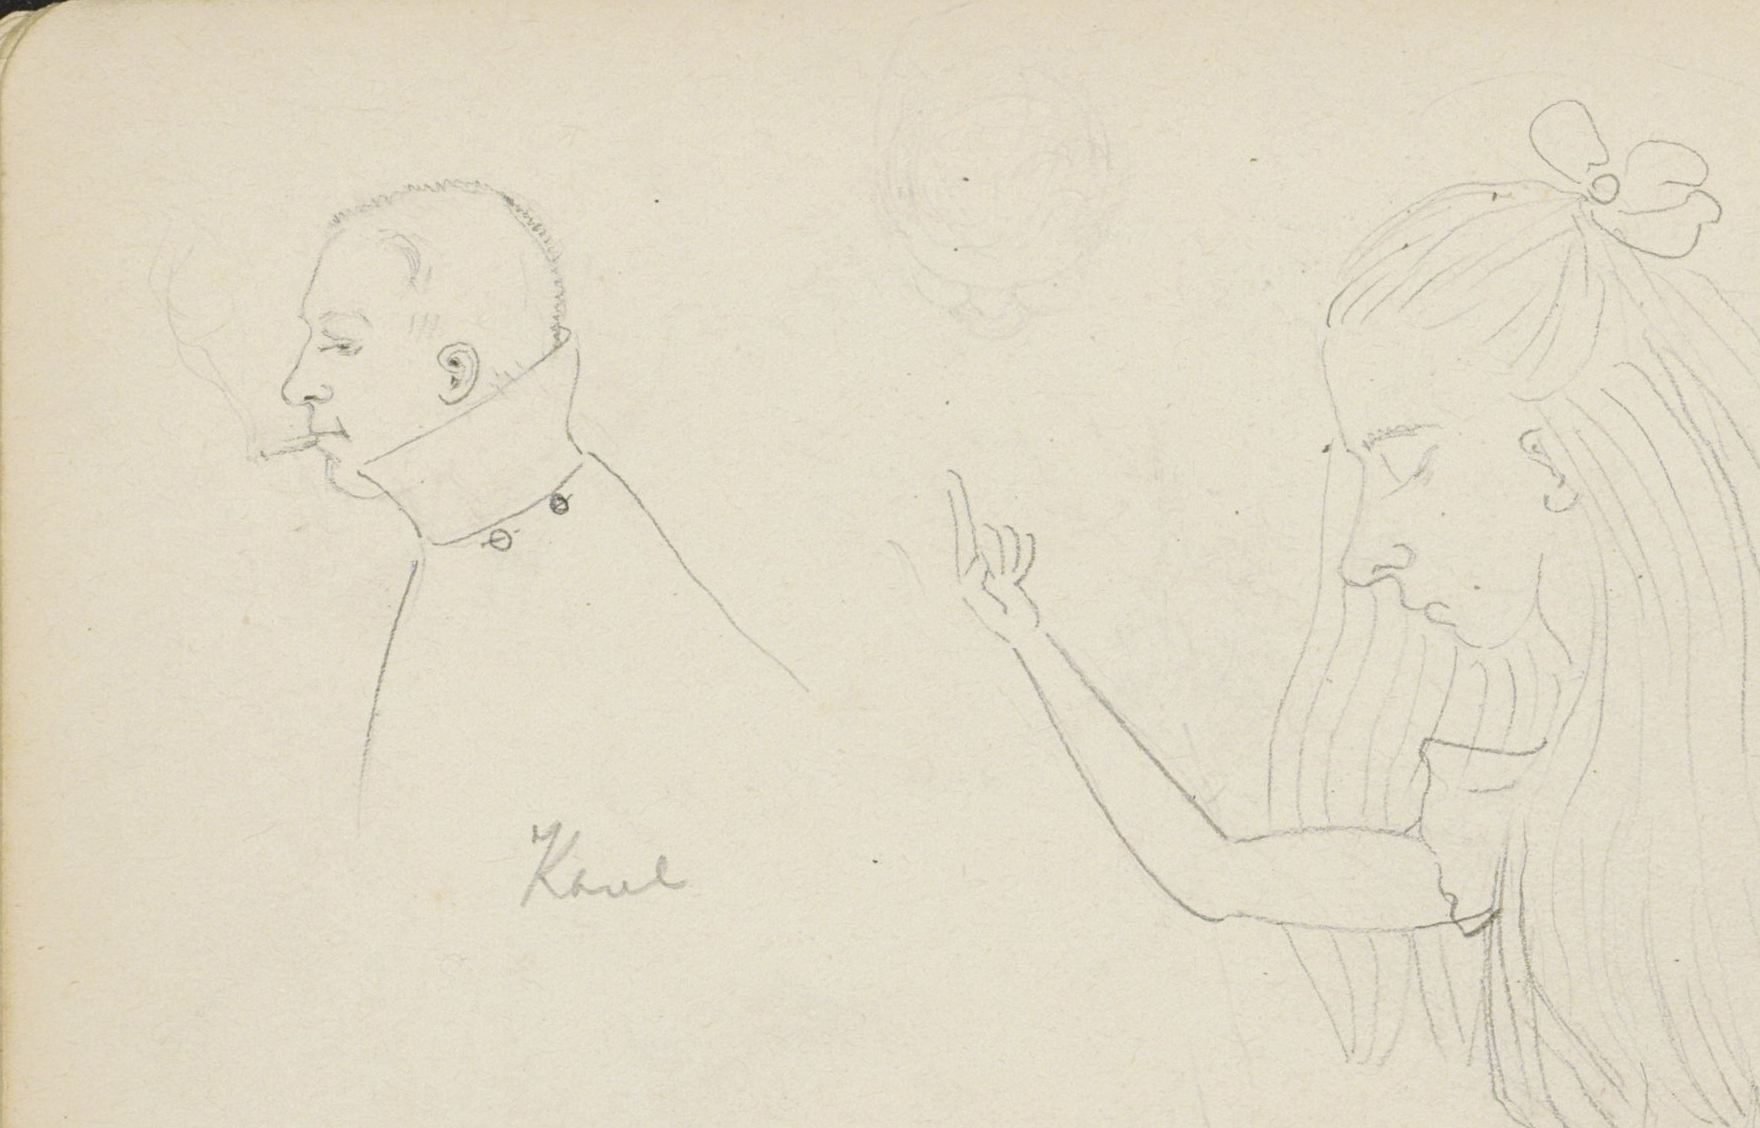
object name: sketchbook leaf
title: Portretkop van een rokende Karel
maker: julie de graag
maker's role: draughtsman, print maker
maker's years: 1877-1924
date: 1894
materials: paper, pencil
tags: postures and gestures of hand and fingers, head (human), cigarette, adult man, girl (child between toddler and youth)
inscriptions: annotation: ‘Karel’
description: Tevens een studie van een meisje met een strik in haar lange haren dat een vinger opsteekt terwijl zij met de andere hand ergens op drukt. Blad 11 verso uit een schetsboek met 35 bladen.